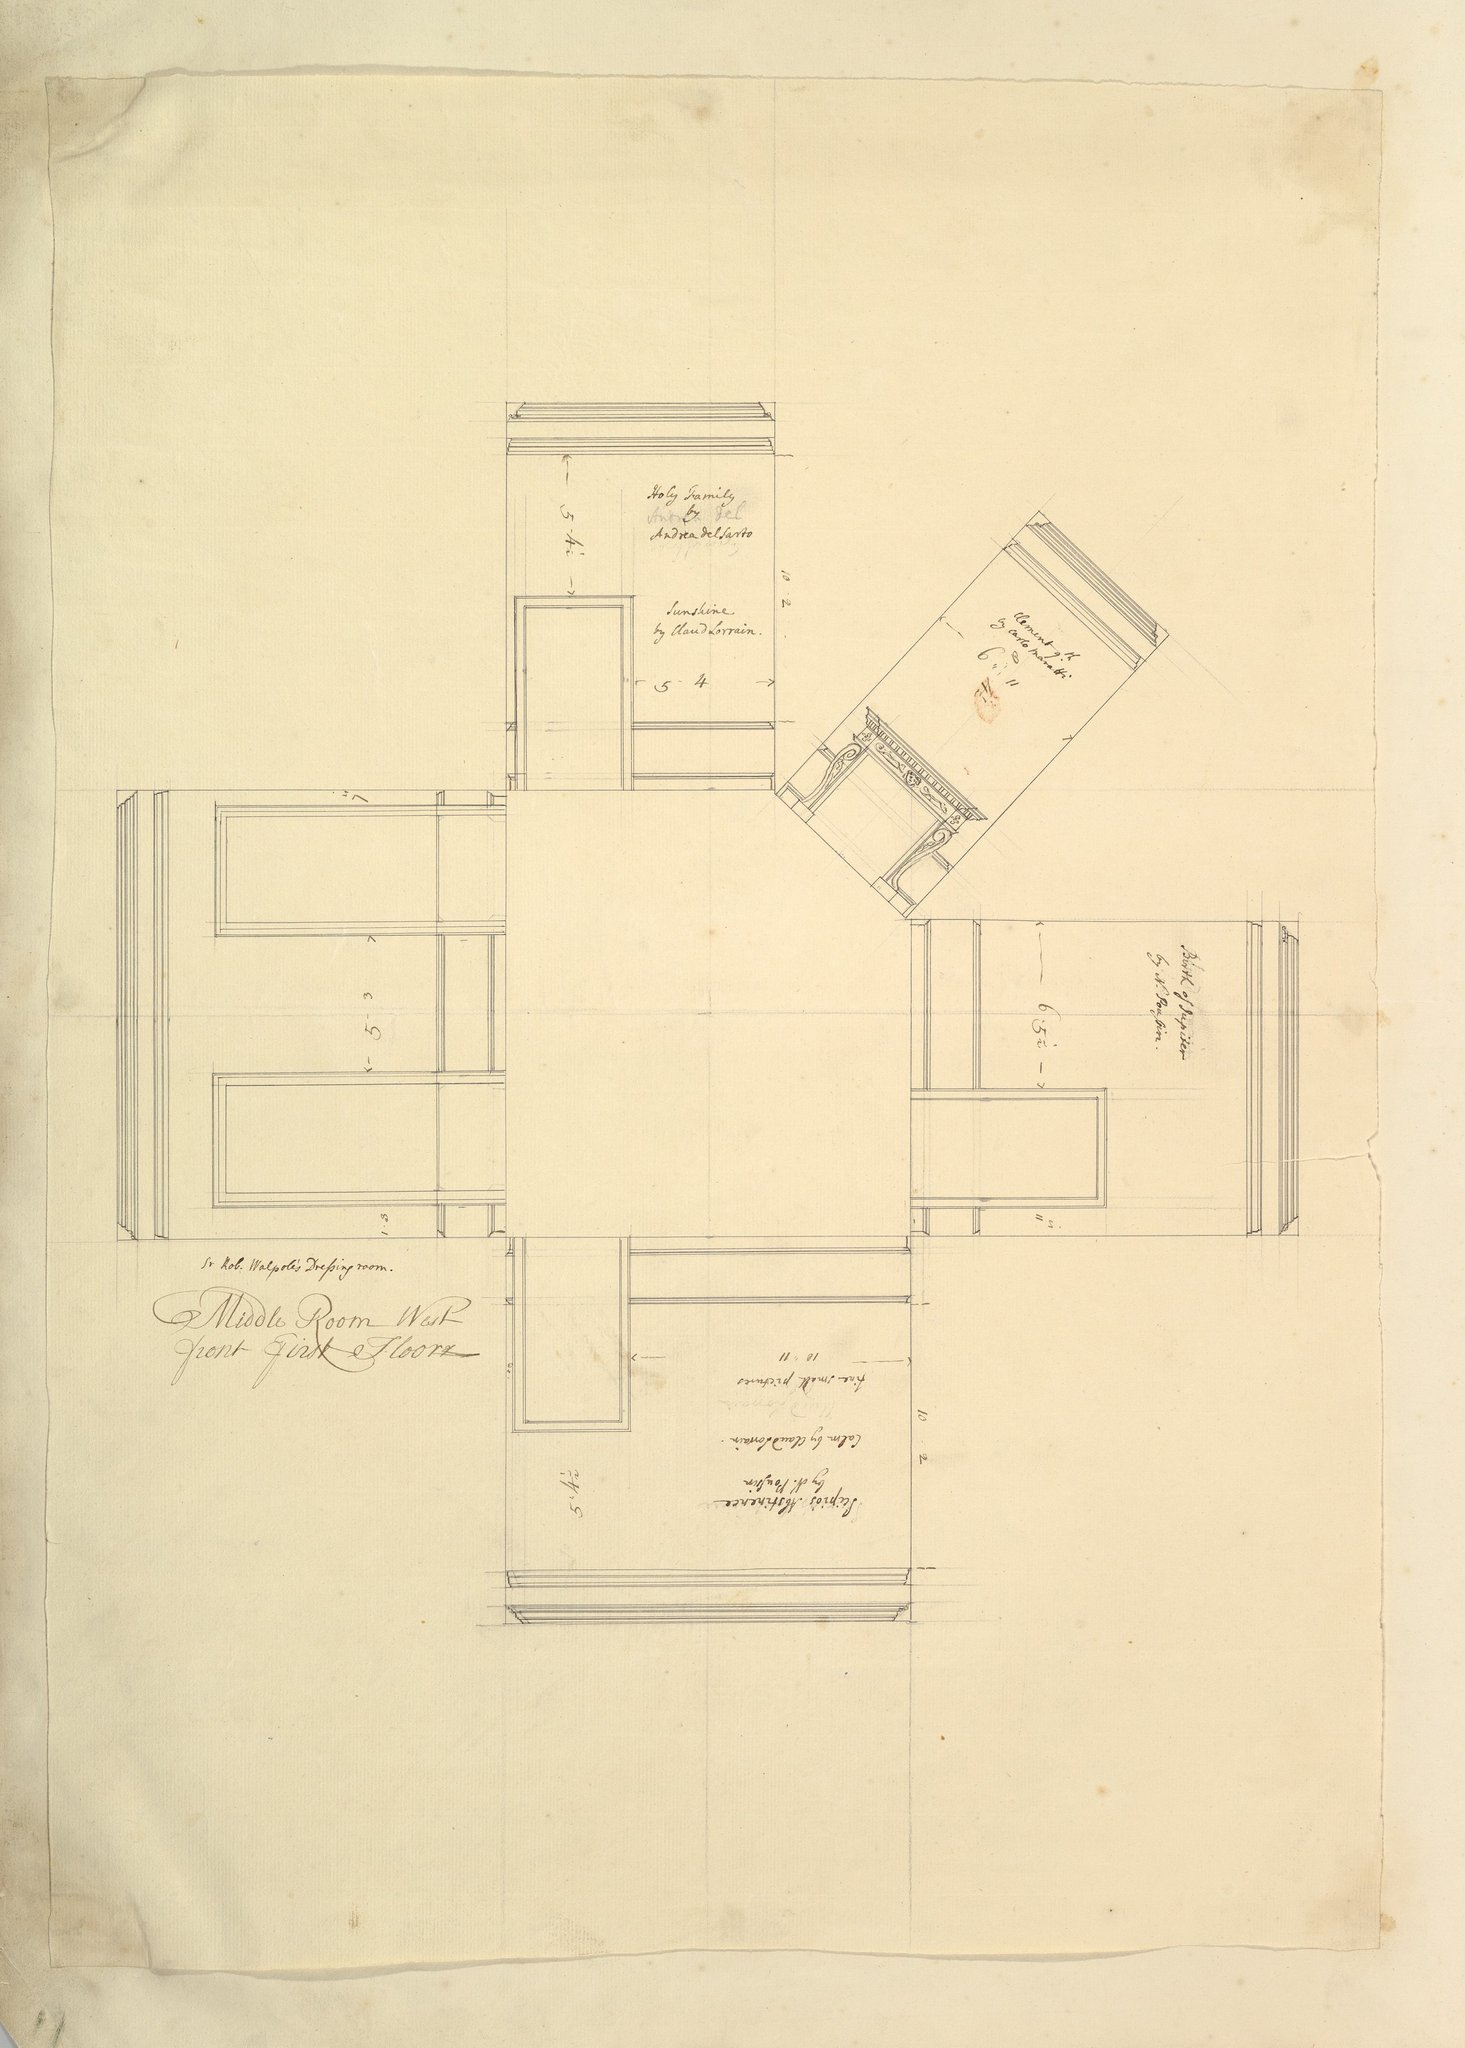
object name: drawing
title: Treasury House, 10 Downing Street, London: Plan of Sir Robert Walpole's Dressing Room (Middle Room, West Front, First Floor)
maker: isaac ware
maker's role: artist and architect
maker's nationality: british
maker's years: 1704-1766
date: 1732-1742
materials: ink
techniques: pen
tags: architecture,houses